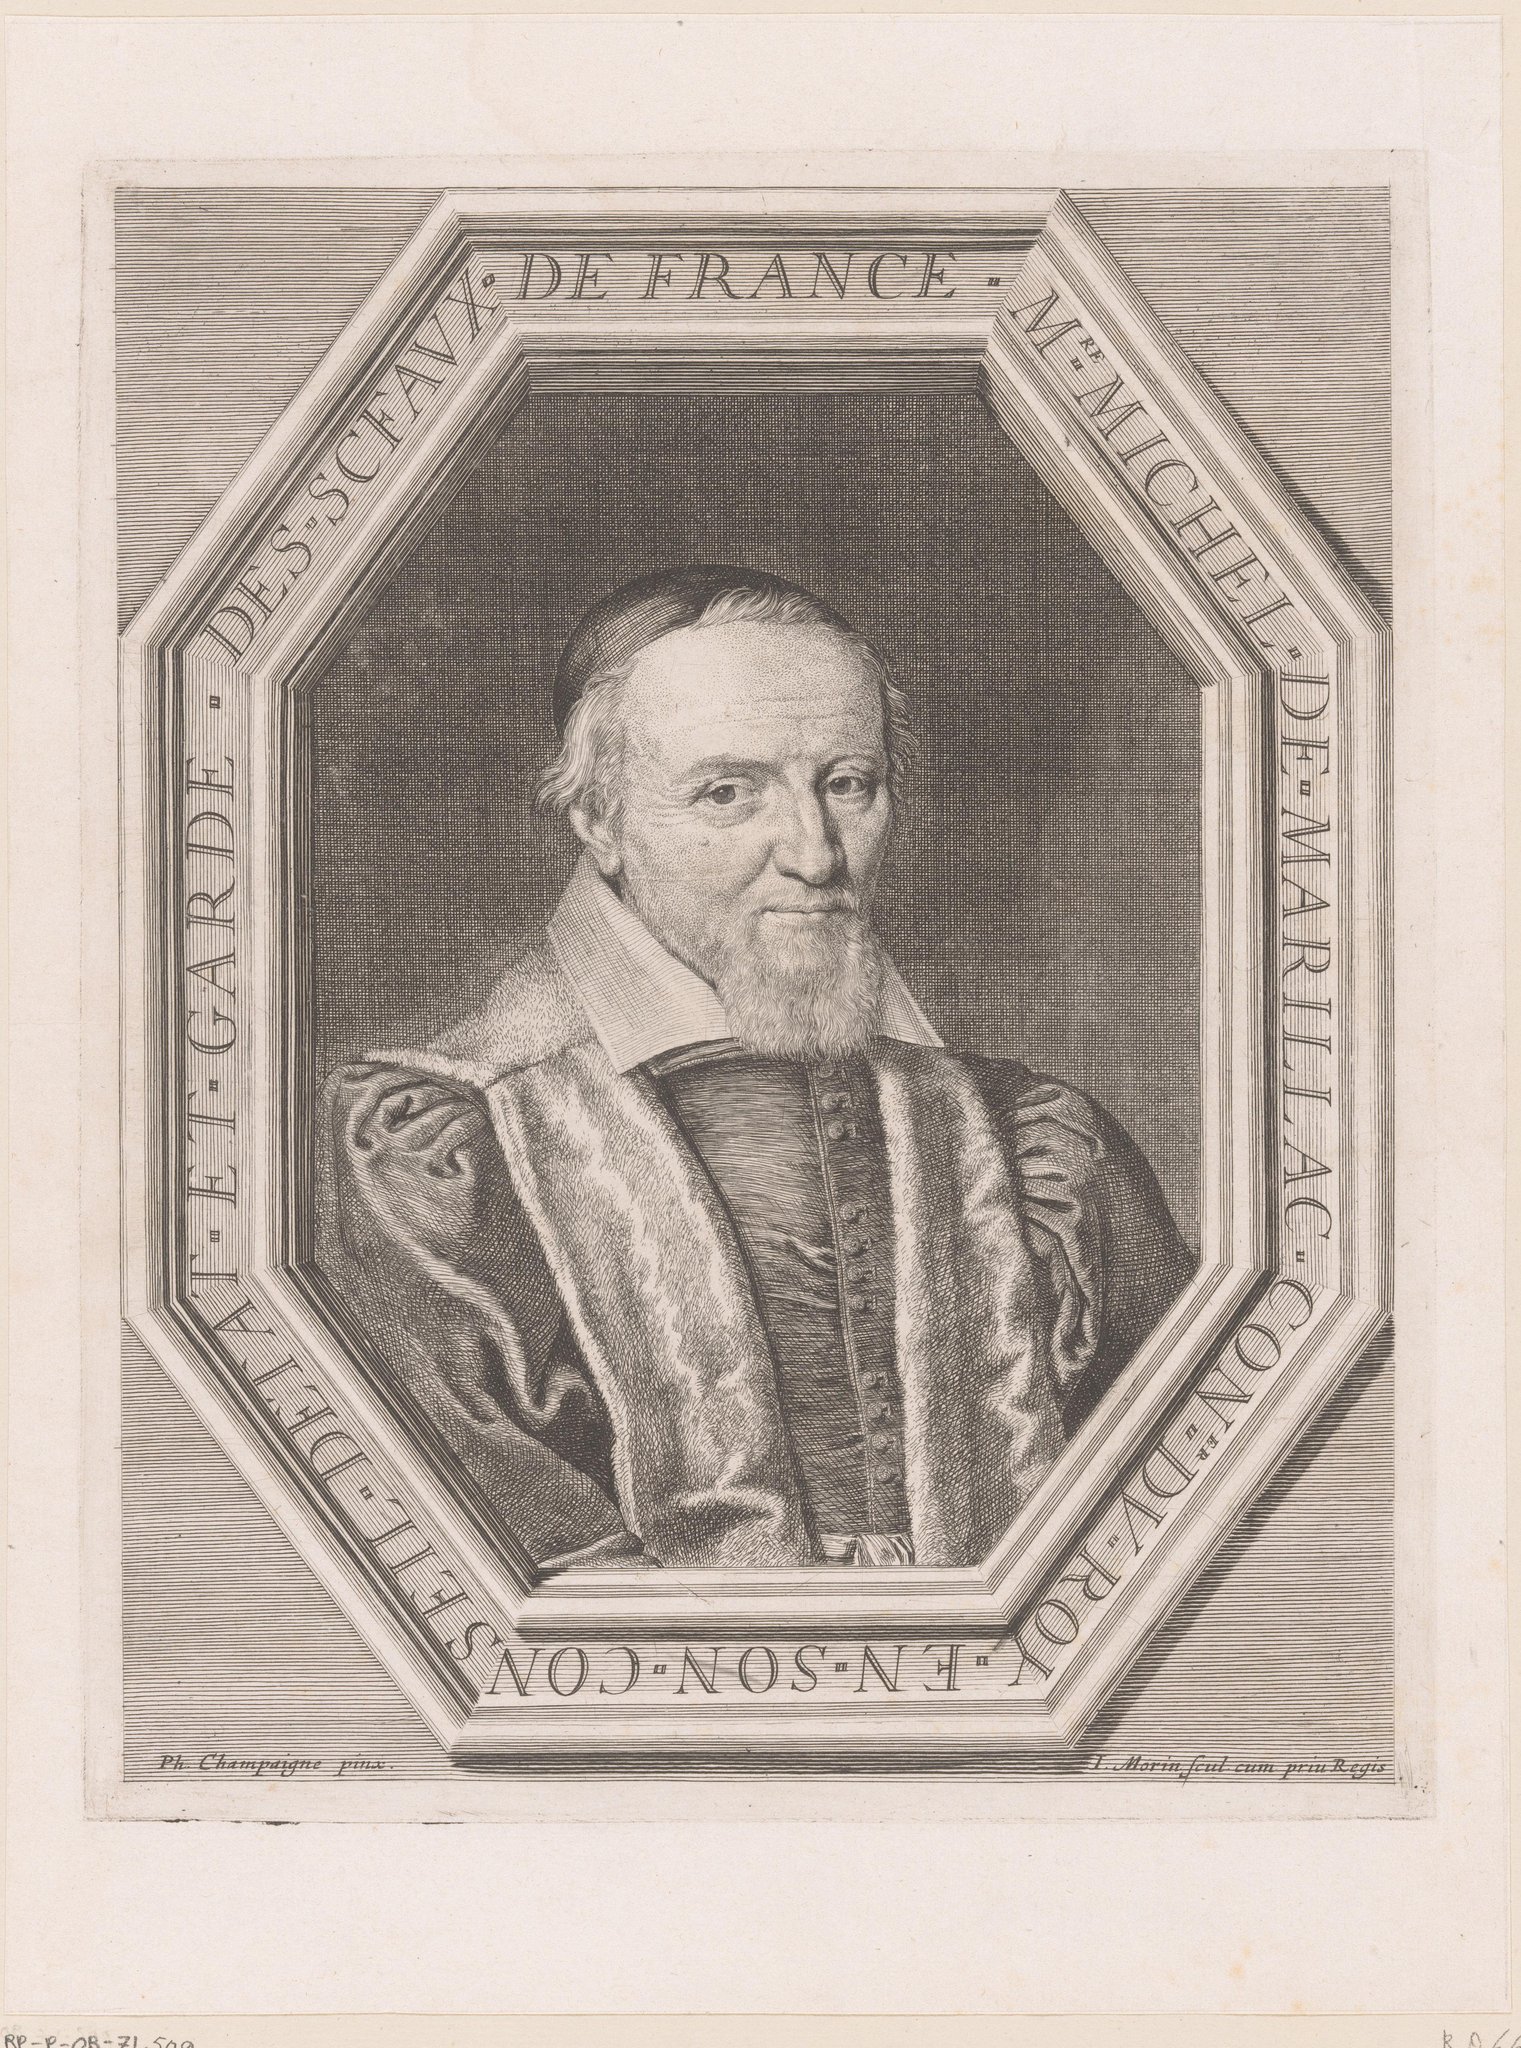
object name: print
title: Portret van Michel de Marillac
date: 1630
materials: paper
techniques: engraving, etching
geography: france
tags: paris, historical persons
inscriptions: collector's mark: Lugt 2228